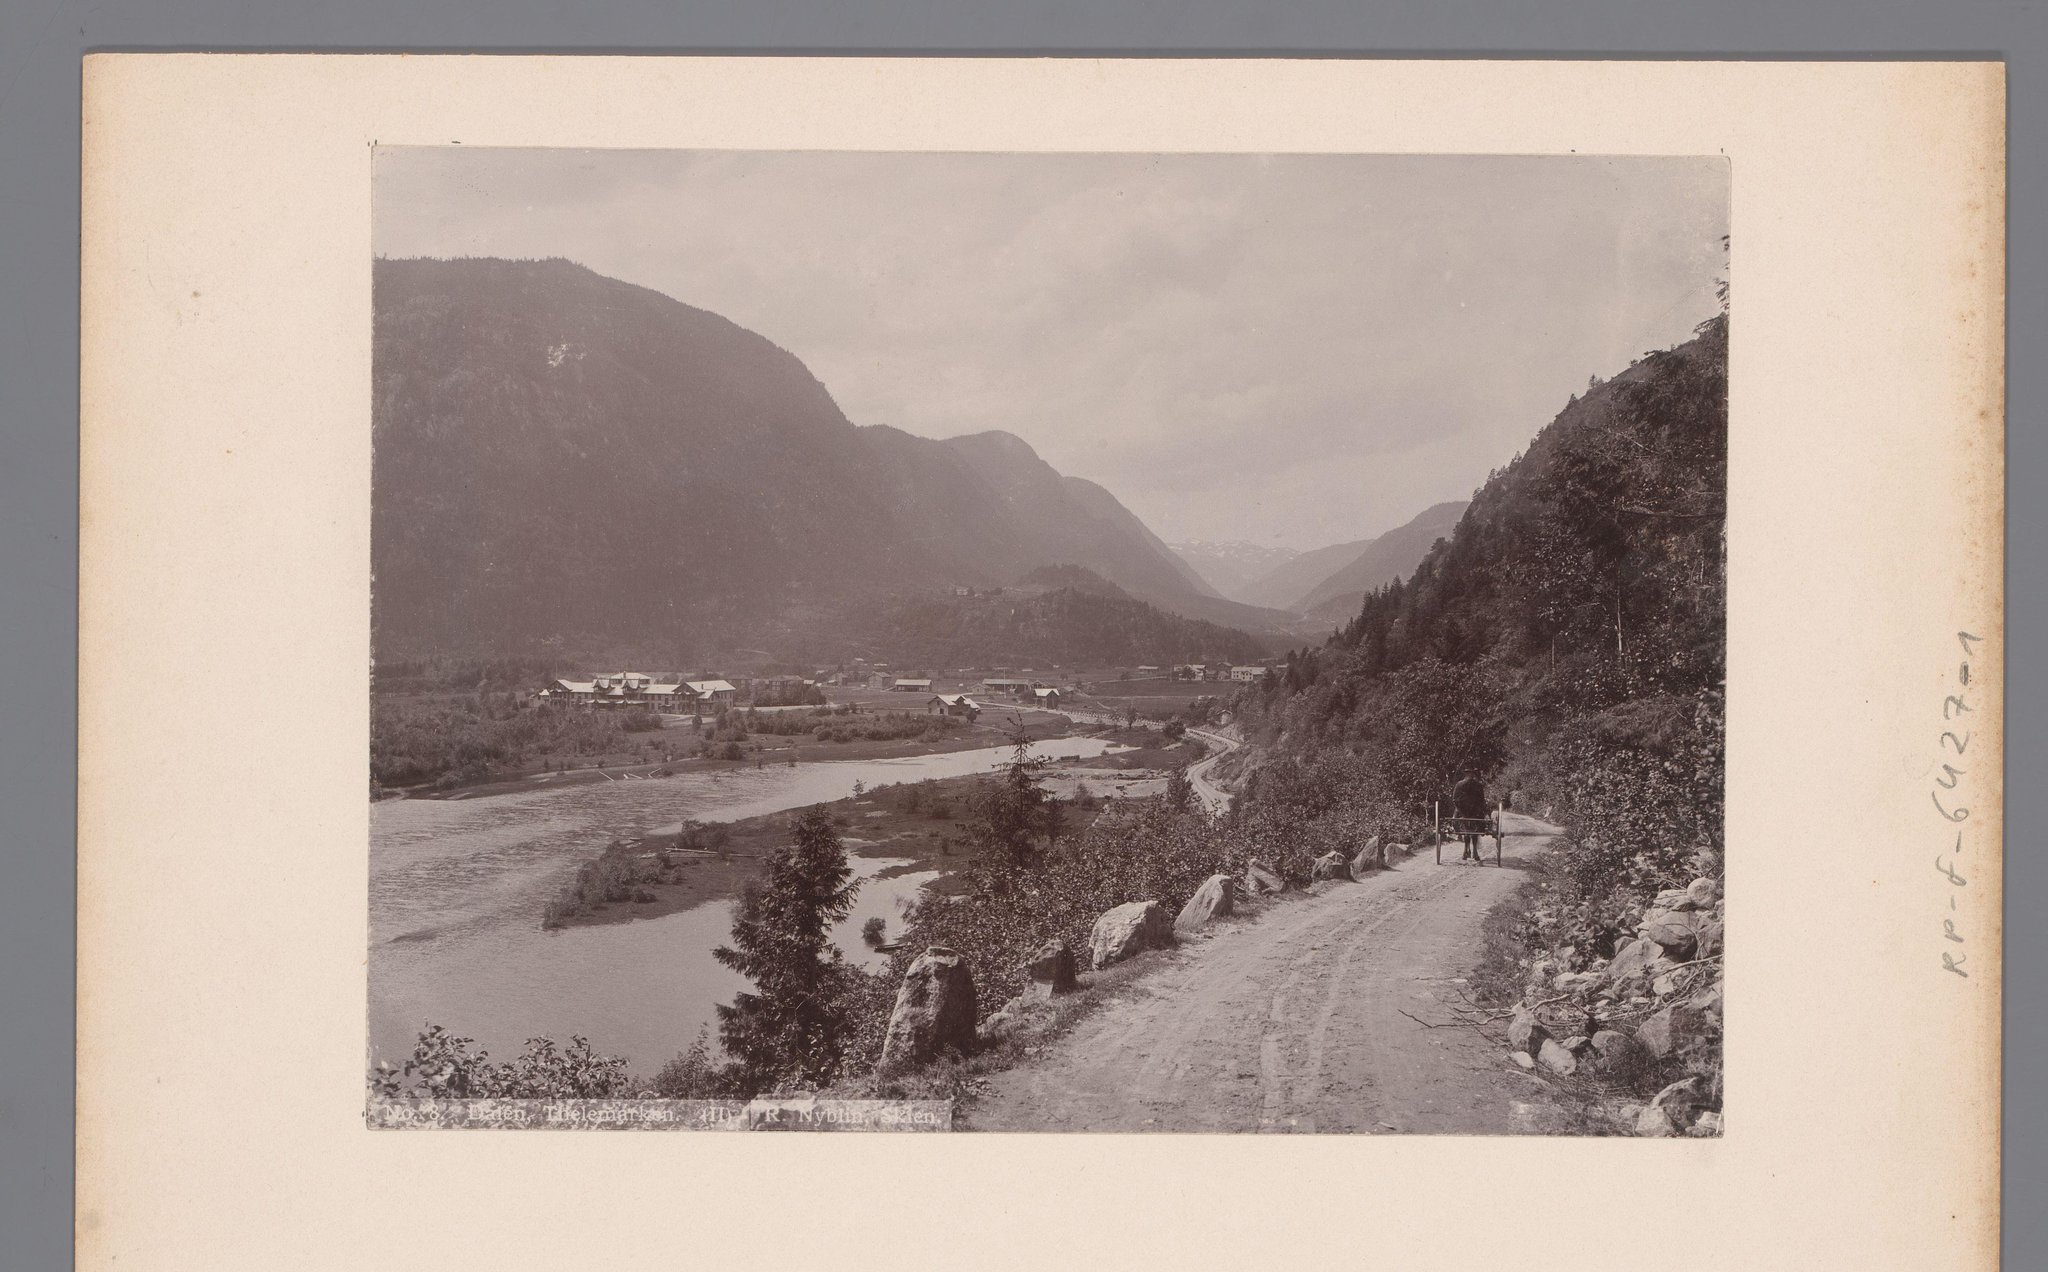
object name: photograph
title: Dalen, Telemark [of Telemakren], Noorwegen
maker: ragnvald nyblin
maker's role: fotograaf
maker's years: 1867-1914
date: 1896-1910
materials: cardboard, photographic support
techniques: collodion silver print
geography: skien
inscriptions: caption: ‘No. 8. Dalen, Thelemarken. (II)’, caption: ‘R. Nyblin, Skien.’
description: Gezicht op een vallei met een meer en bergen eromheen, gezien vanaf een weg met daarop een paardenkar. Links aan de oever het Dalen hotel.